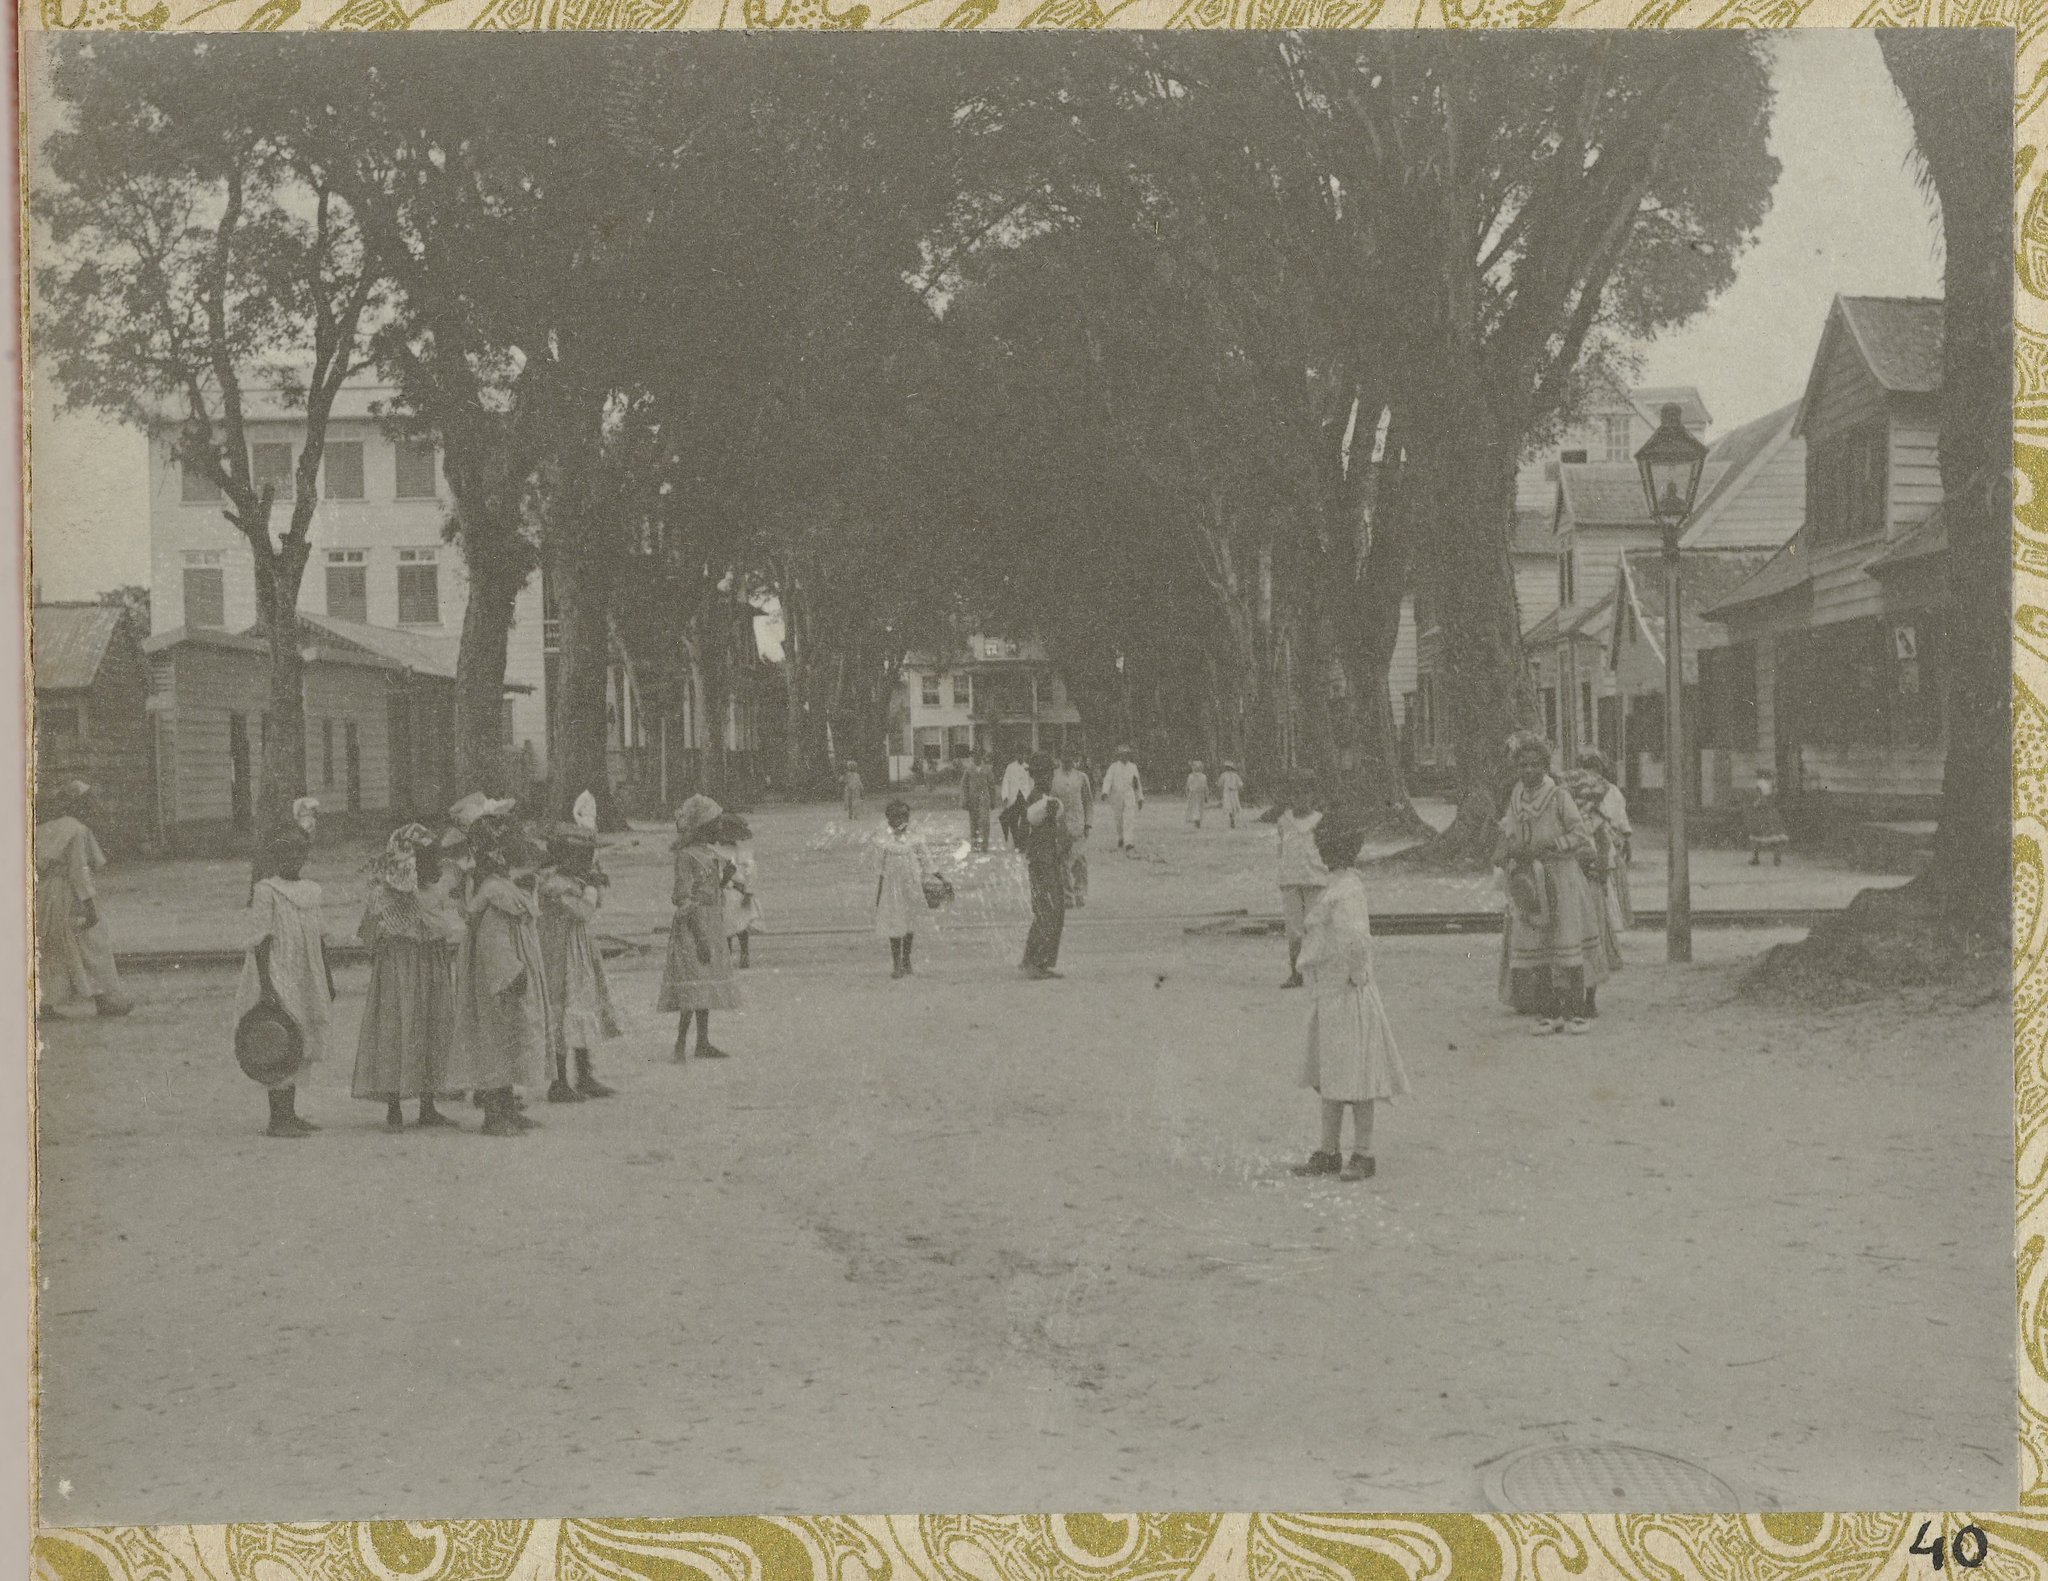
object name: photograph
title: Heerenstraat te Paramaribo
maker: hendrik doijer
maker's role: engineer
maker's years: 1863-1925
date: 1903-1910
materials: photographic support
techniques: gelatin silver print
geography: suriname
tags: suriname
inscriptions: inscription: ‘40’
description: Gezicht in de Heerenstraat te Paramaribo, op de voorgrond een groep meisjes. Onderdeel van het fotoalbum Souvenir de Voyage (deel 2), over het leven van de familie Doijer in en rond de plantage Ma Retraite in Suriname in de jaren 1903-1910.